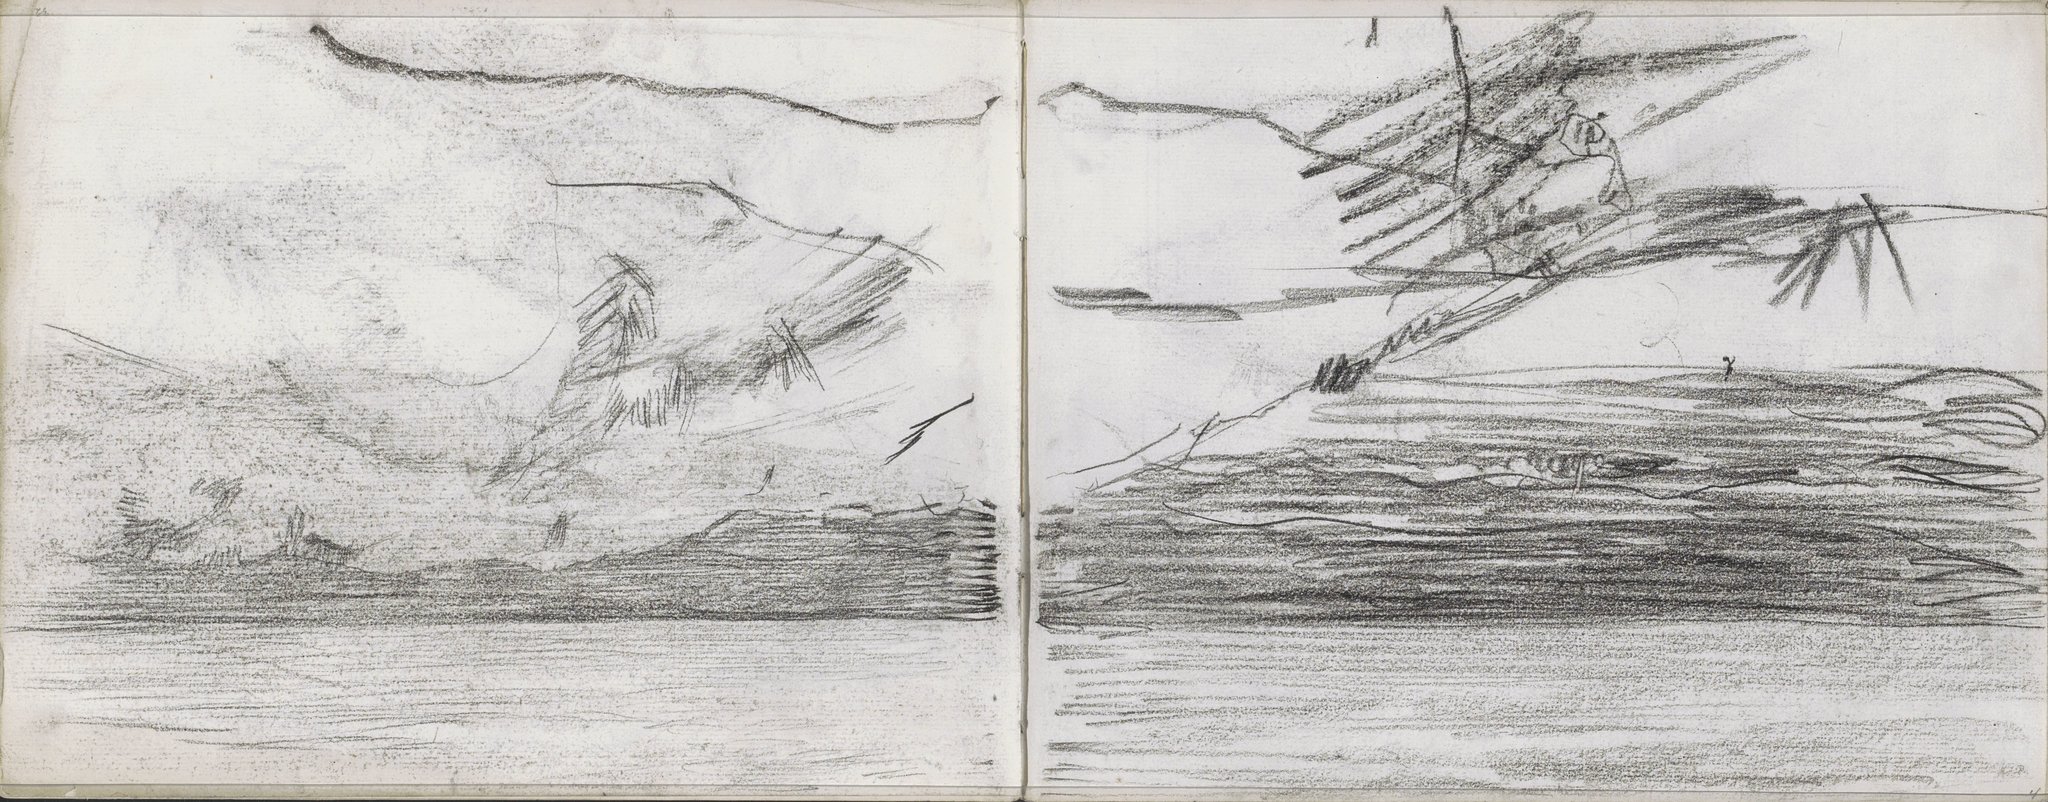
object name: sketchbook leaf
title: Duingezicht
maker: isaac israels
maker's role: draughtsman, painter, print maker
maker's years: 1865-1934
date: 1875-1934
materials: chalk, paper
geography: the hague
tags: dune coast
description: Op de achtergrond de zee. Blad 3 verso uit schetsboek XIV met 17 bladen.